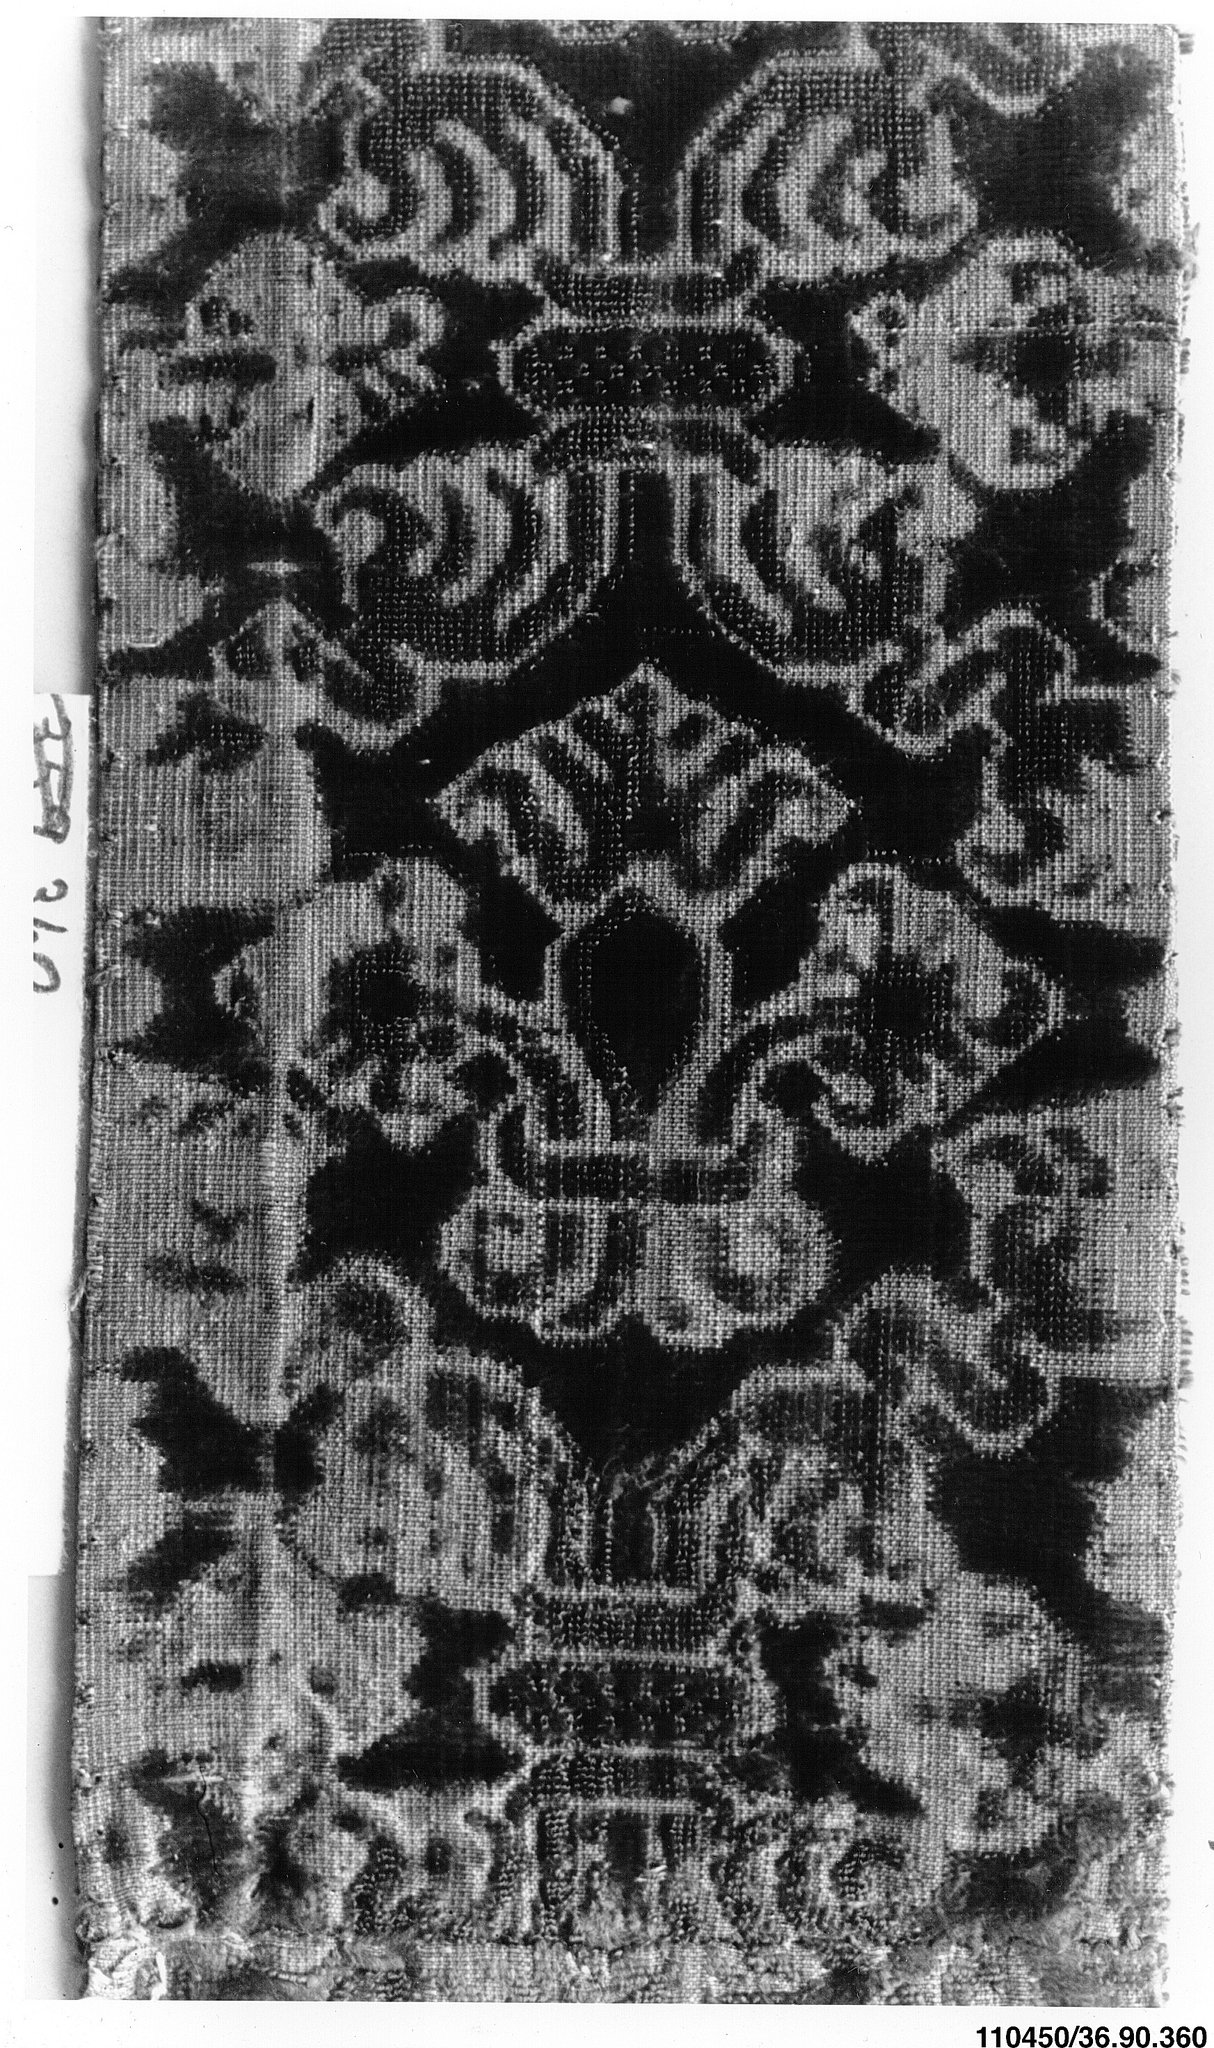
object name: piece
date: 1501-1700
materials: silk